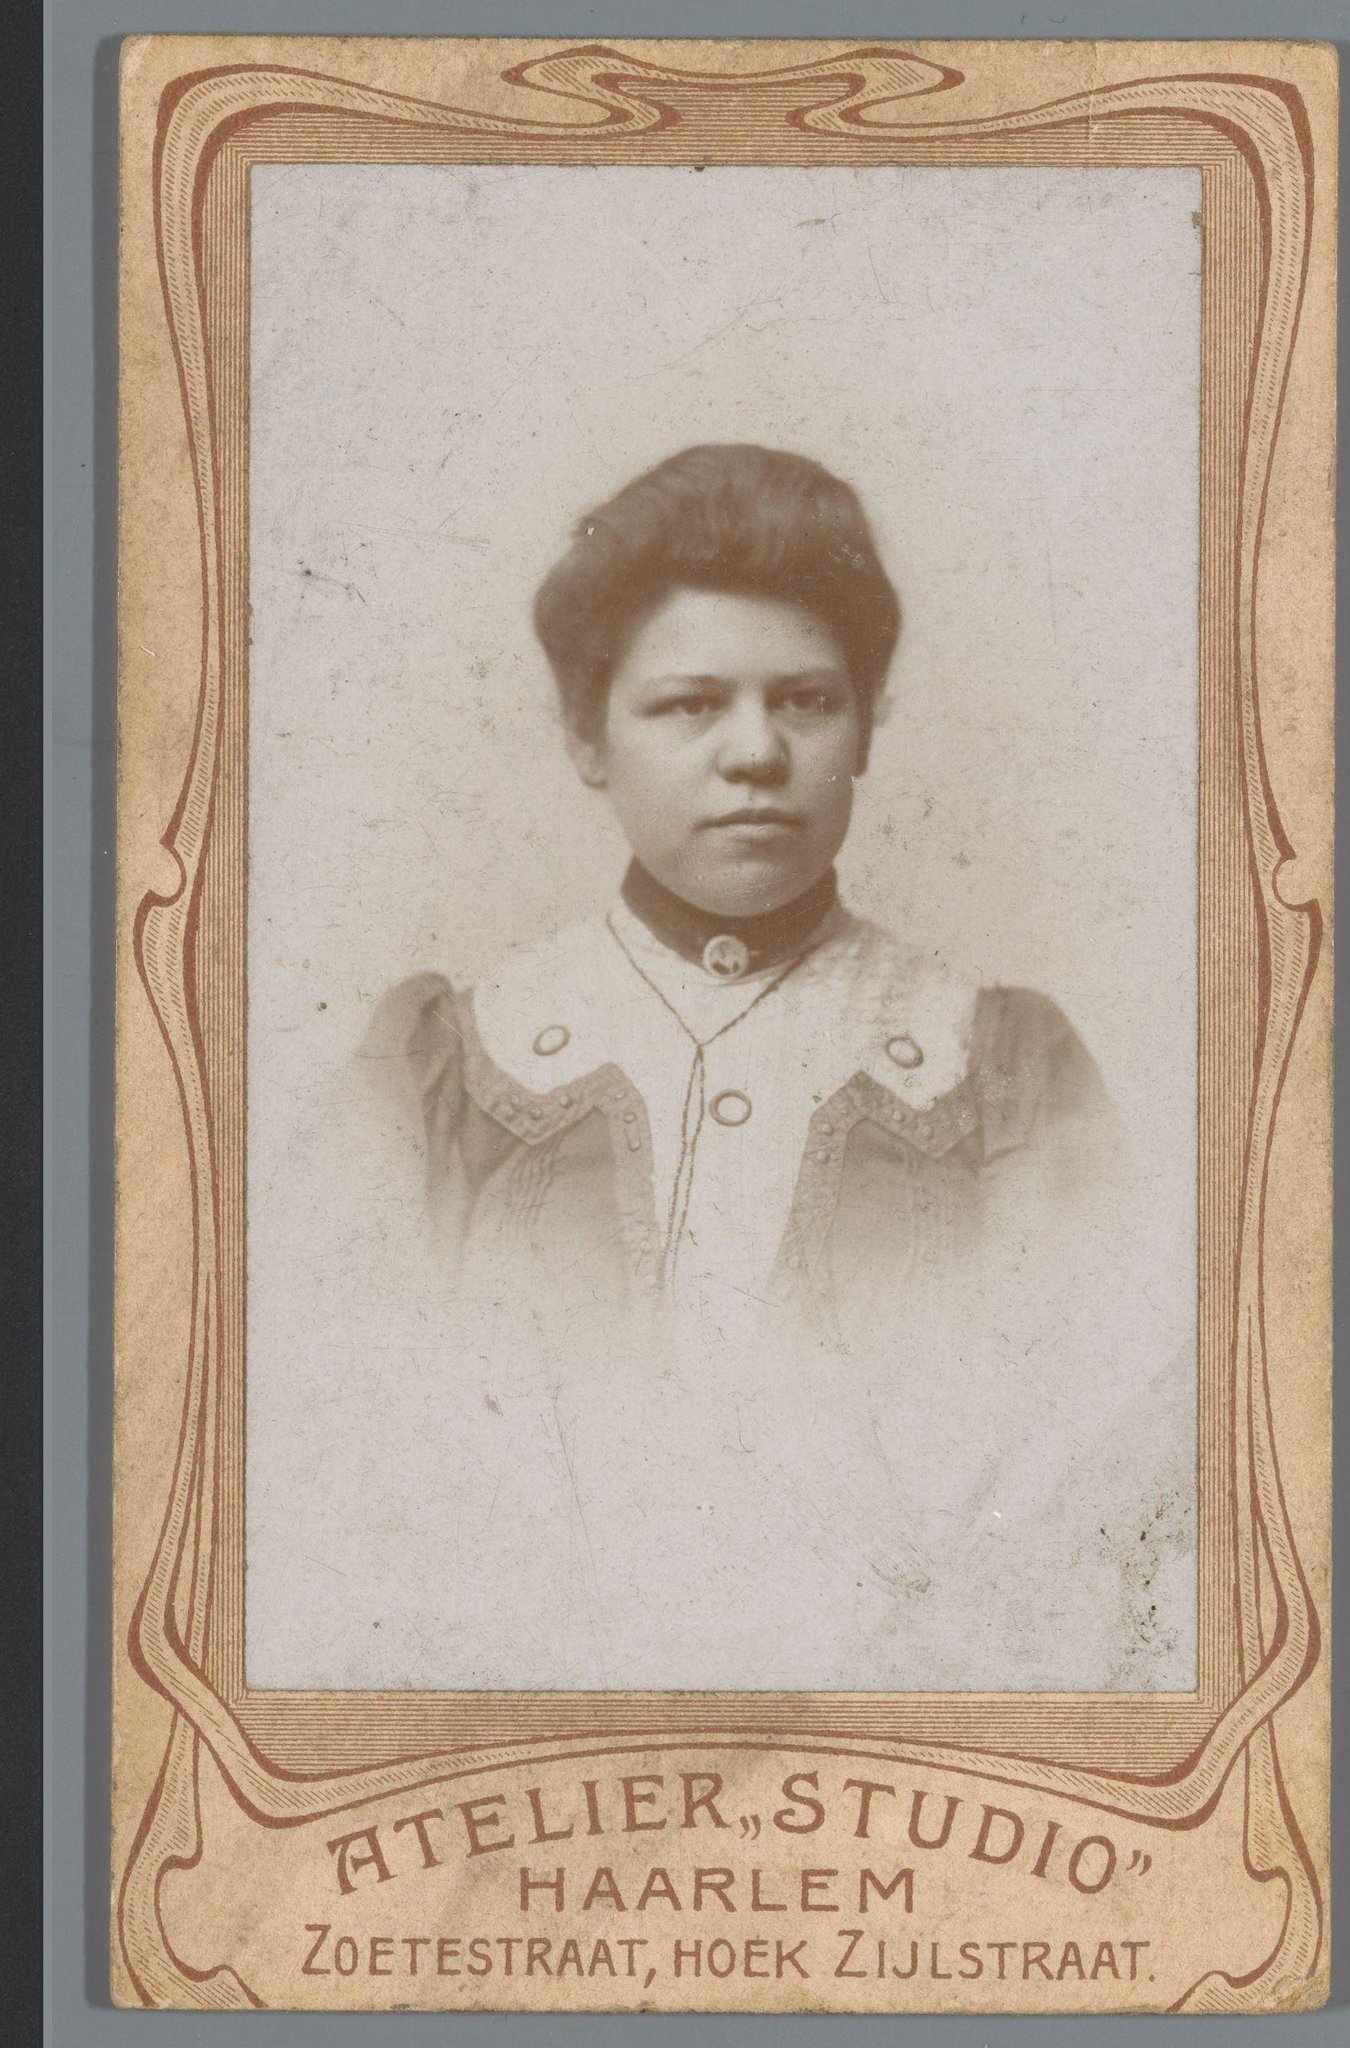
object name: carte de visite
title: Portret van een onbekende vrouw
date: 1895-1904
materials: cardboard, photographic support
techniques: collodion silver print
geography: haarlem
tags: historical persons - bb - woman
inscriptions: inscription: ‘ATELIER "STUDIO"/ HAARLEM/ ZOETESTRAAT, HOEK ZIJLSTRAAT.’